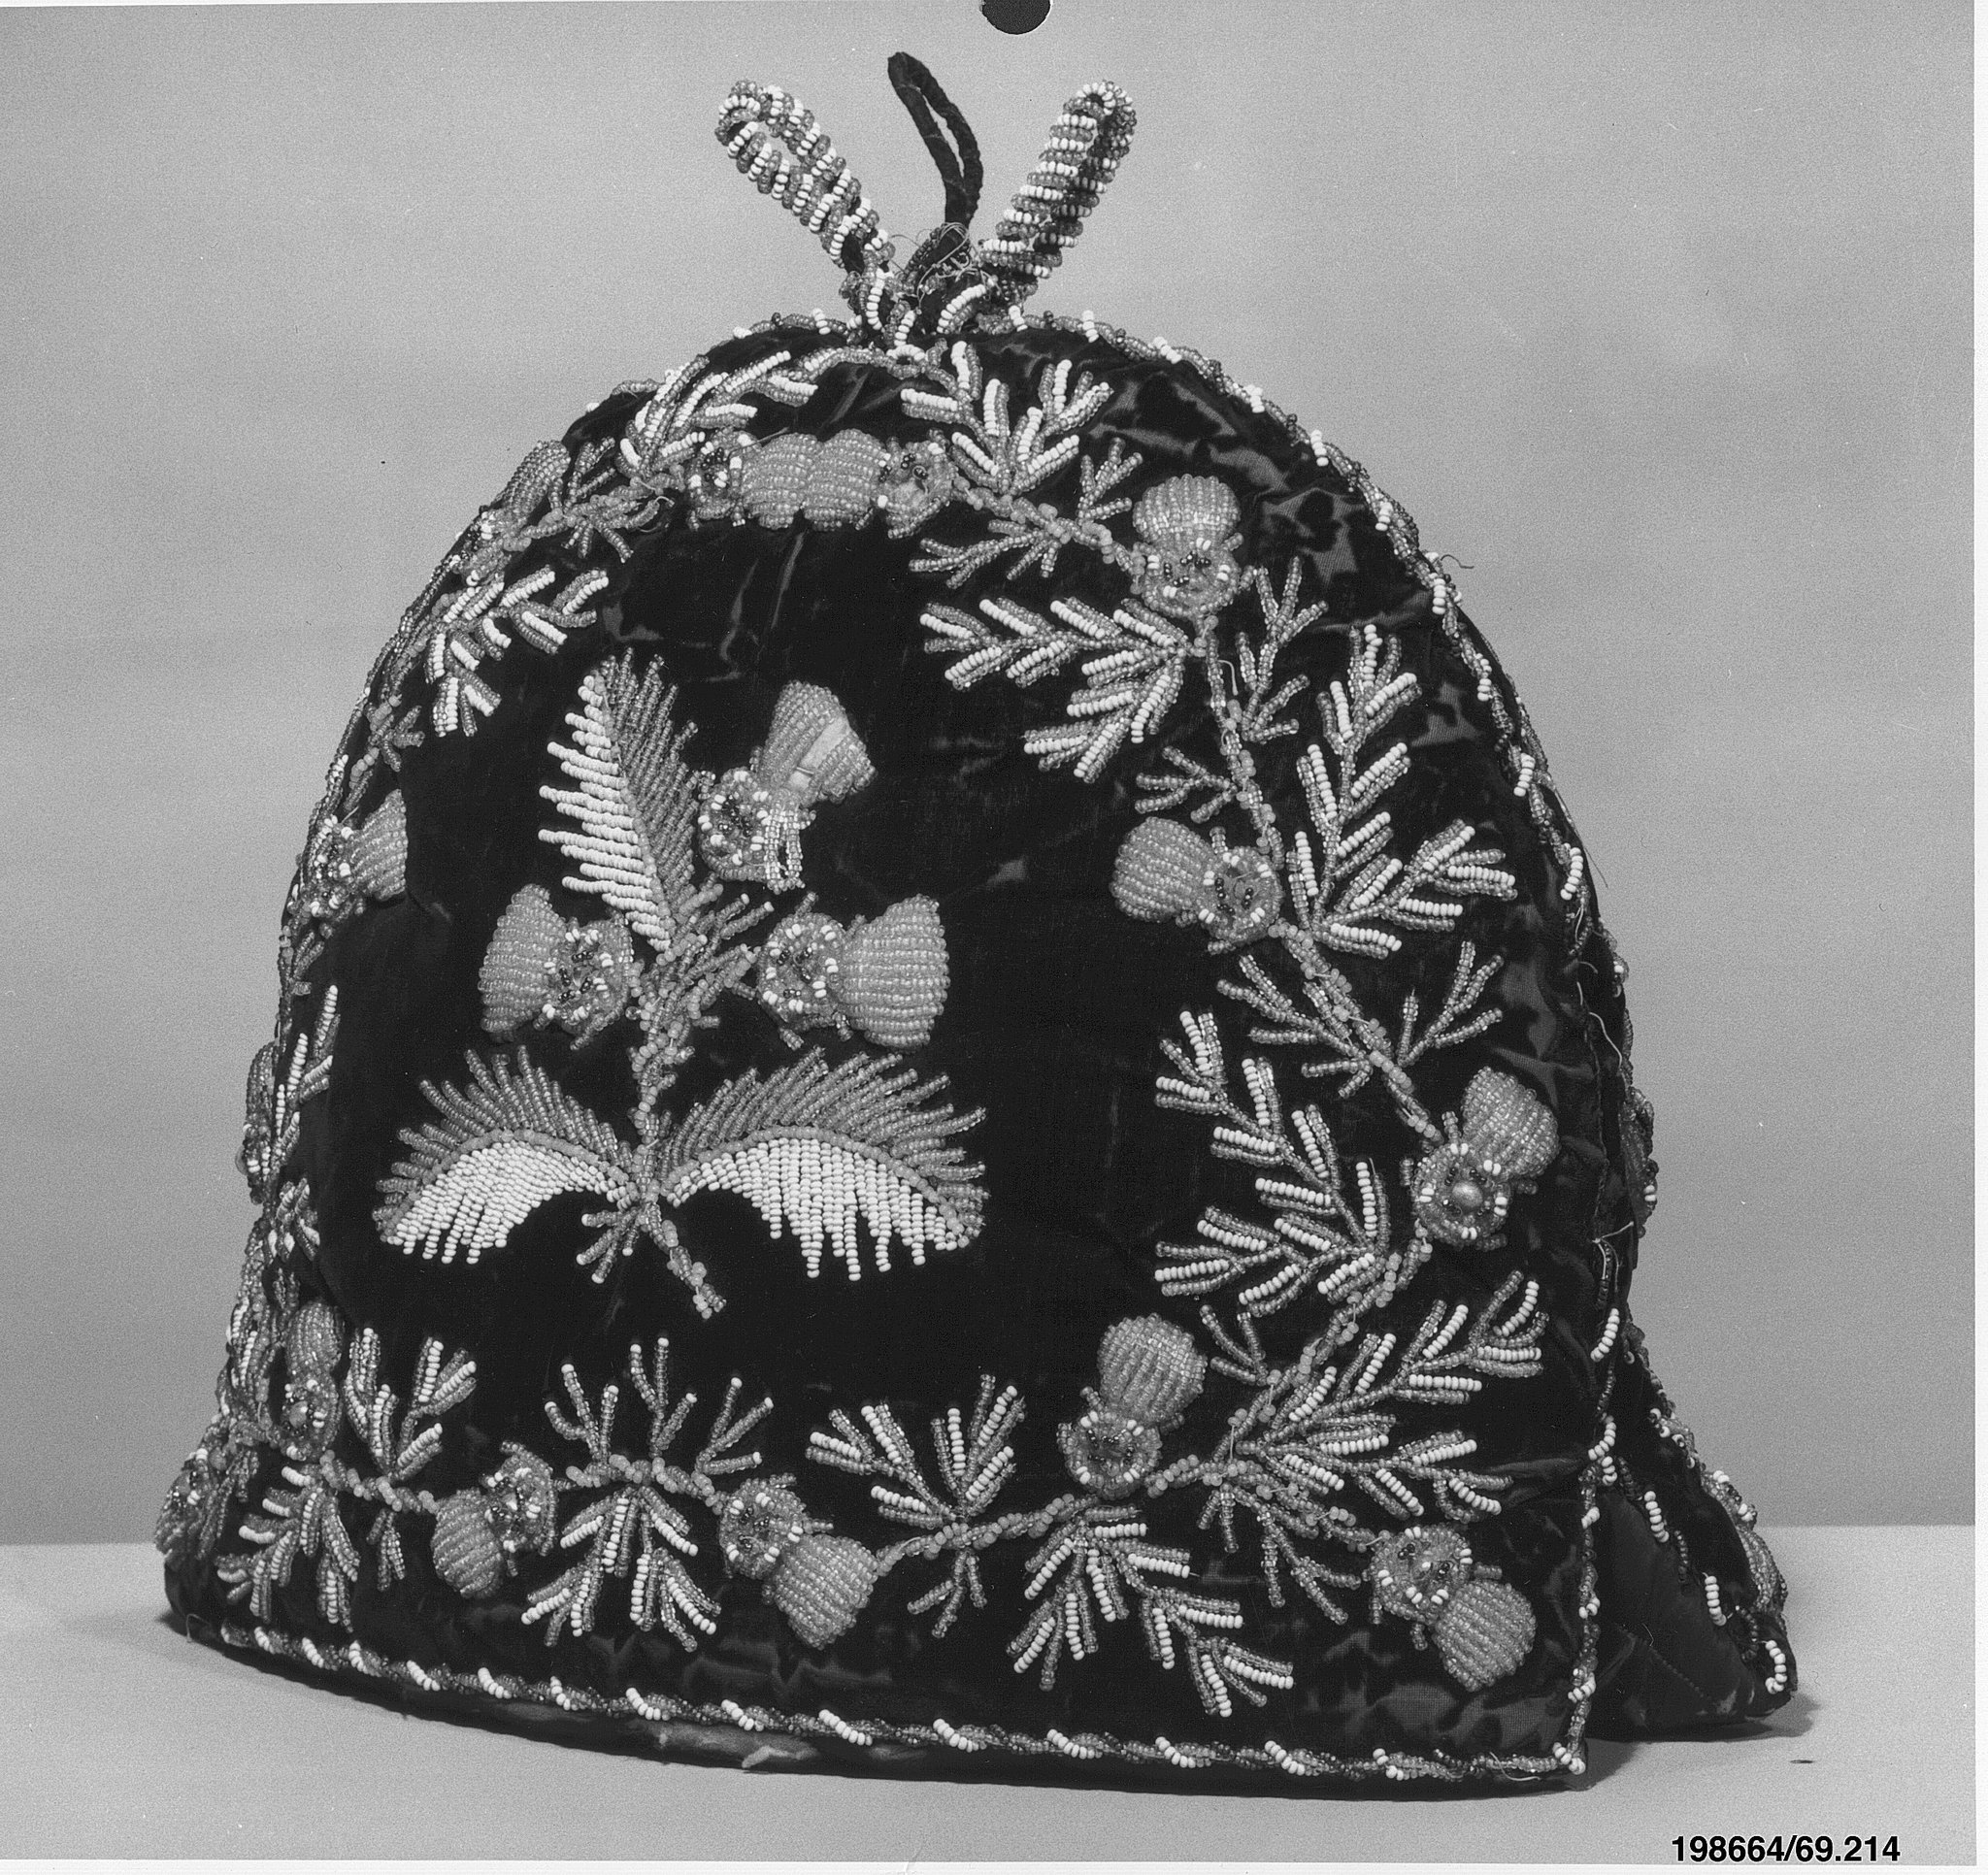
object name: tea cozy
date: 1801-1900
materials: glass, silk